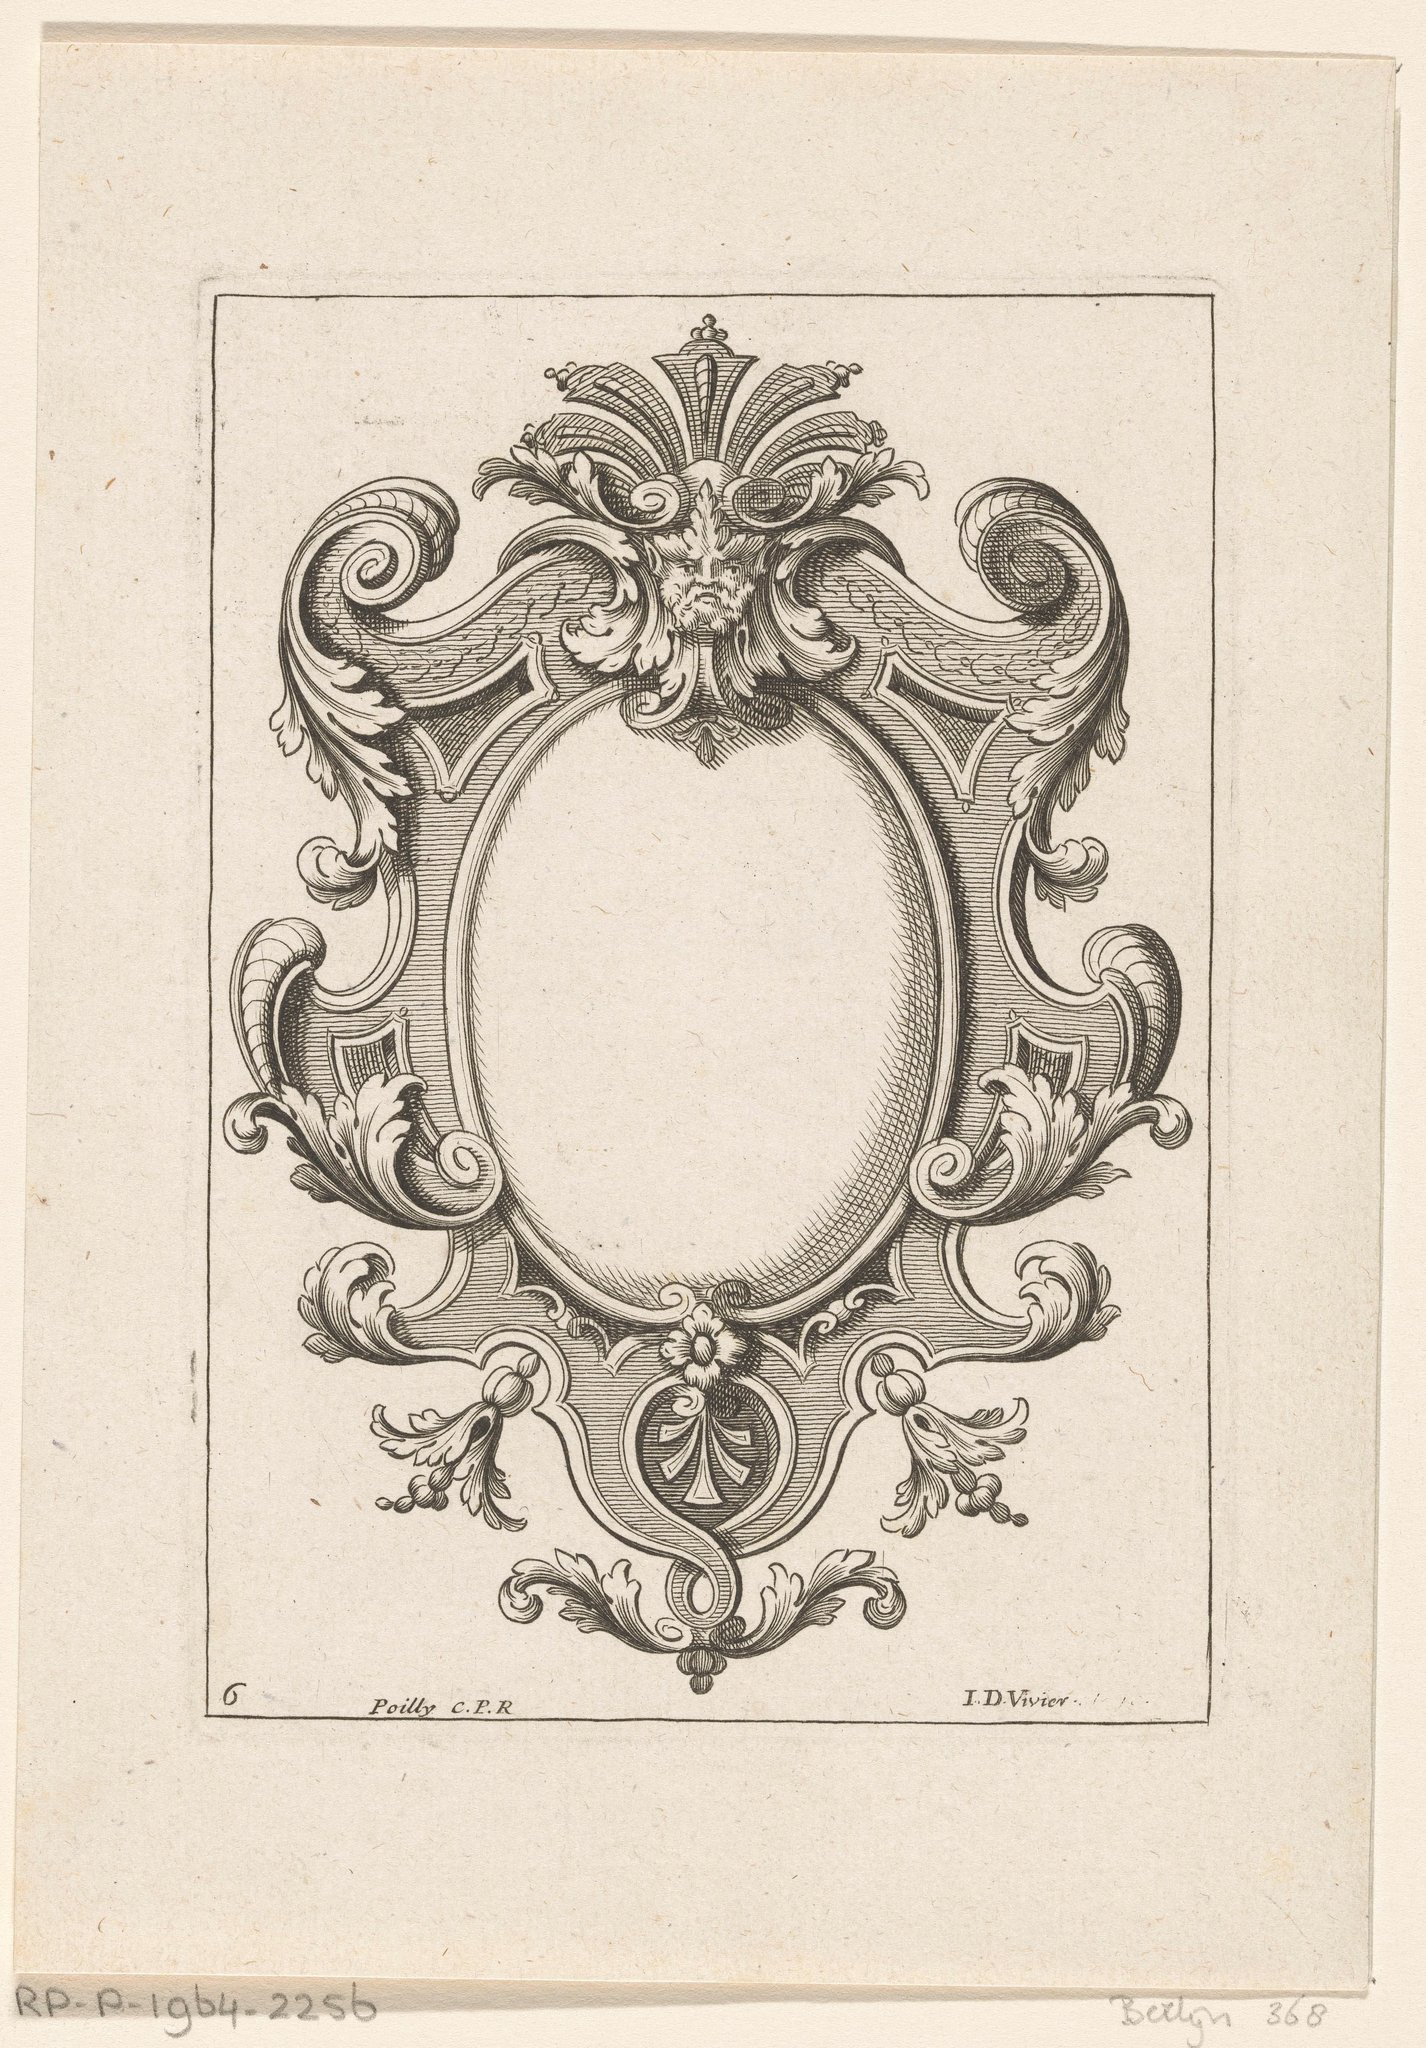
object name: ornament print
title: Cartouche met masker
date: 1712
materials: paper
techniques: engraving, etching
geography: paris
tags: ornament ~ cartouche, mask, mascaron ~ ornament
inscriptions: collector's mark: Lugt 2228, collector's mark: Lugt 2760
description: Een cartouche met een masker en bladmotieven.